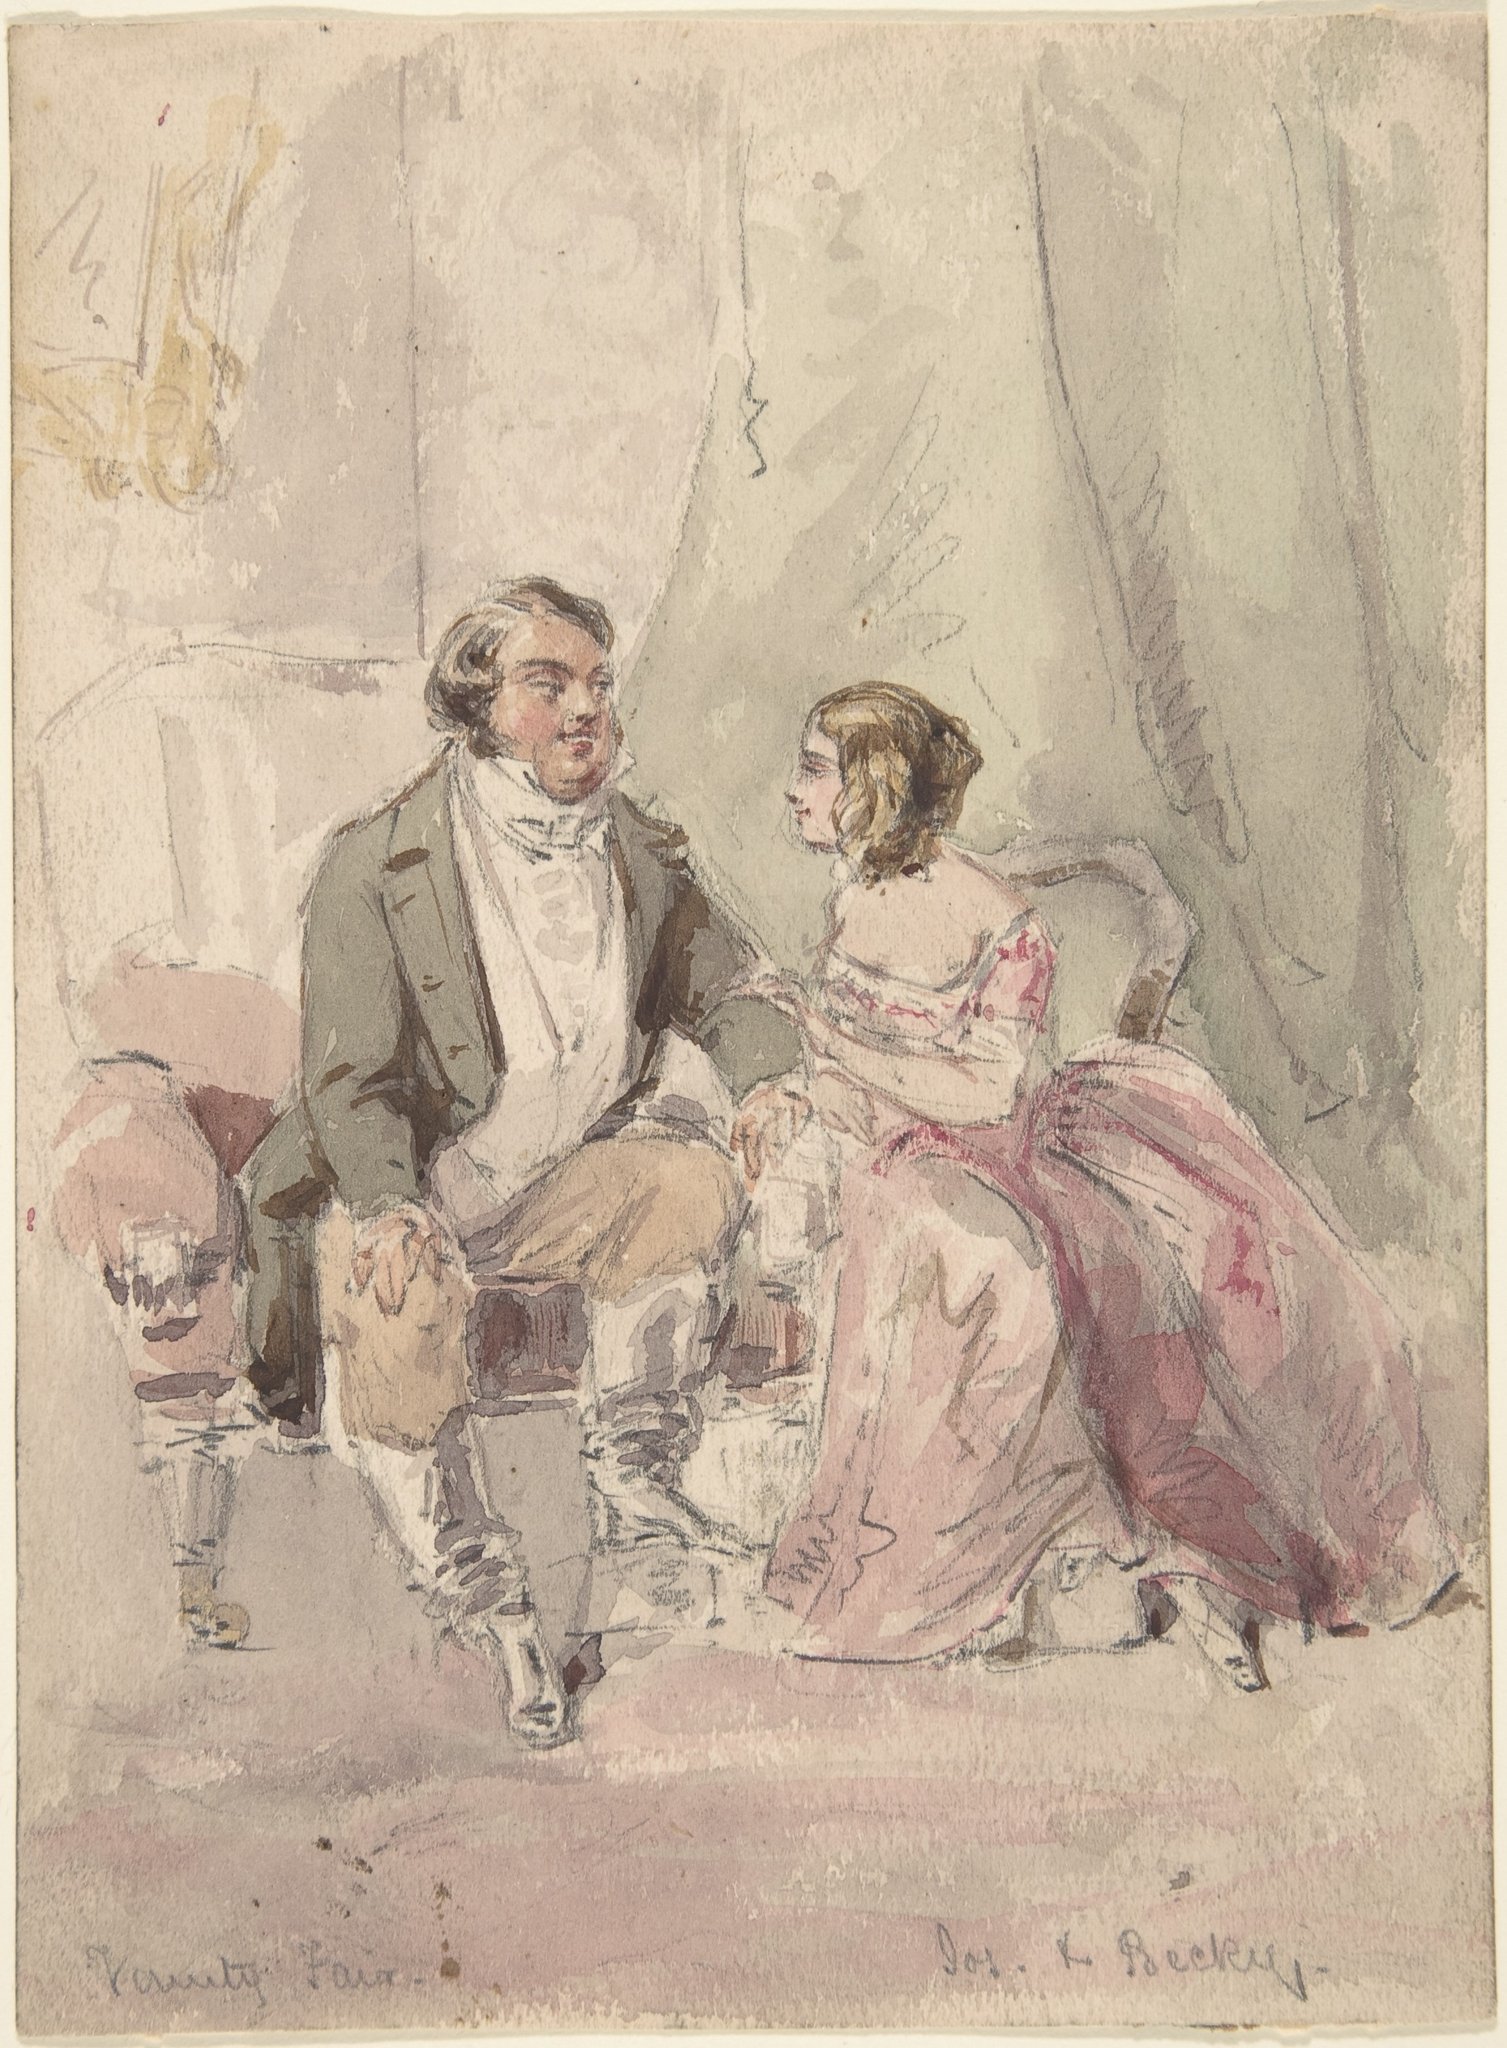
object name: drawing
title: Illustration to Vanity Fair, Chapter 1: "Jos and Becky"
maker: william makepeace thackeray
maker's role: artist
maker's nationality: british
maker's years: 1811-1863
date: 1848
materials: graphite, watercolor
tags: girls,men